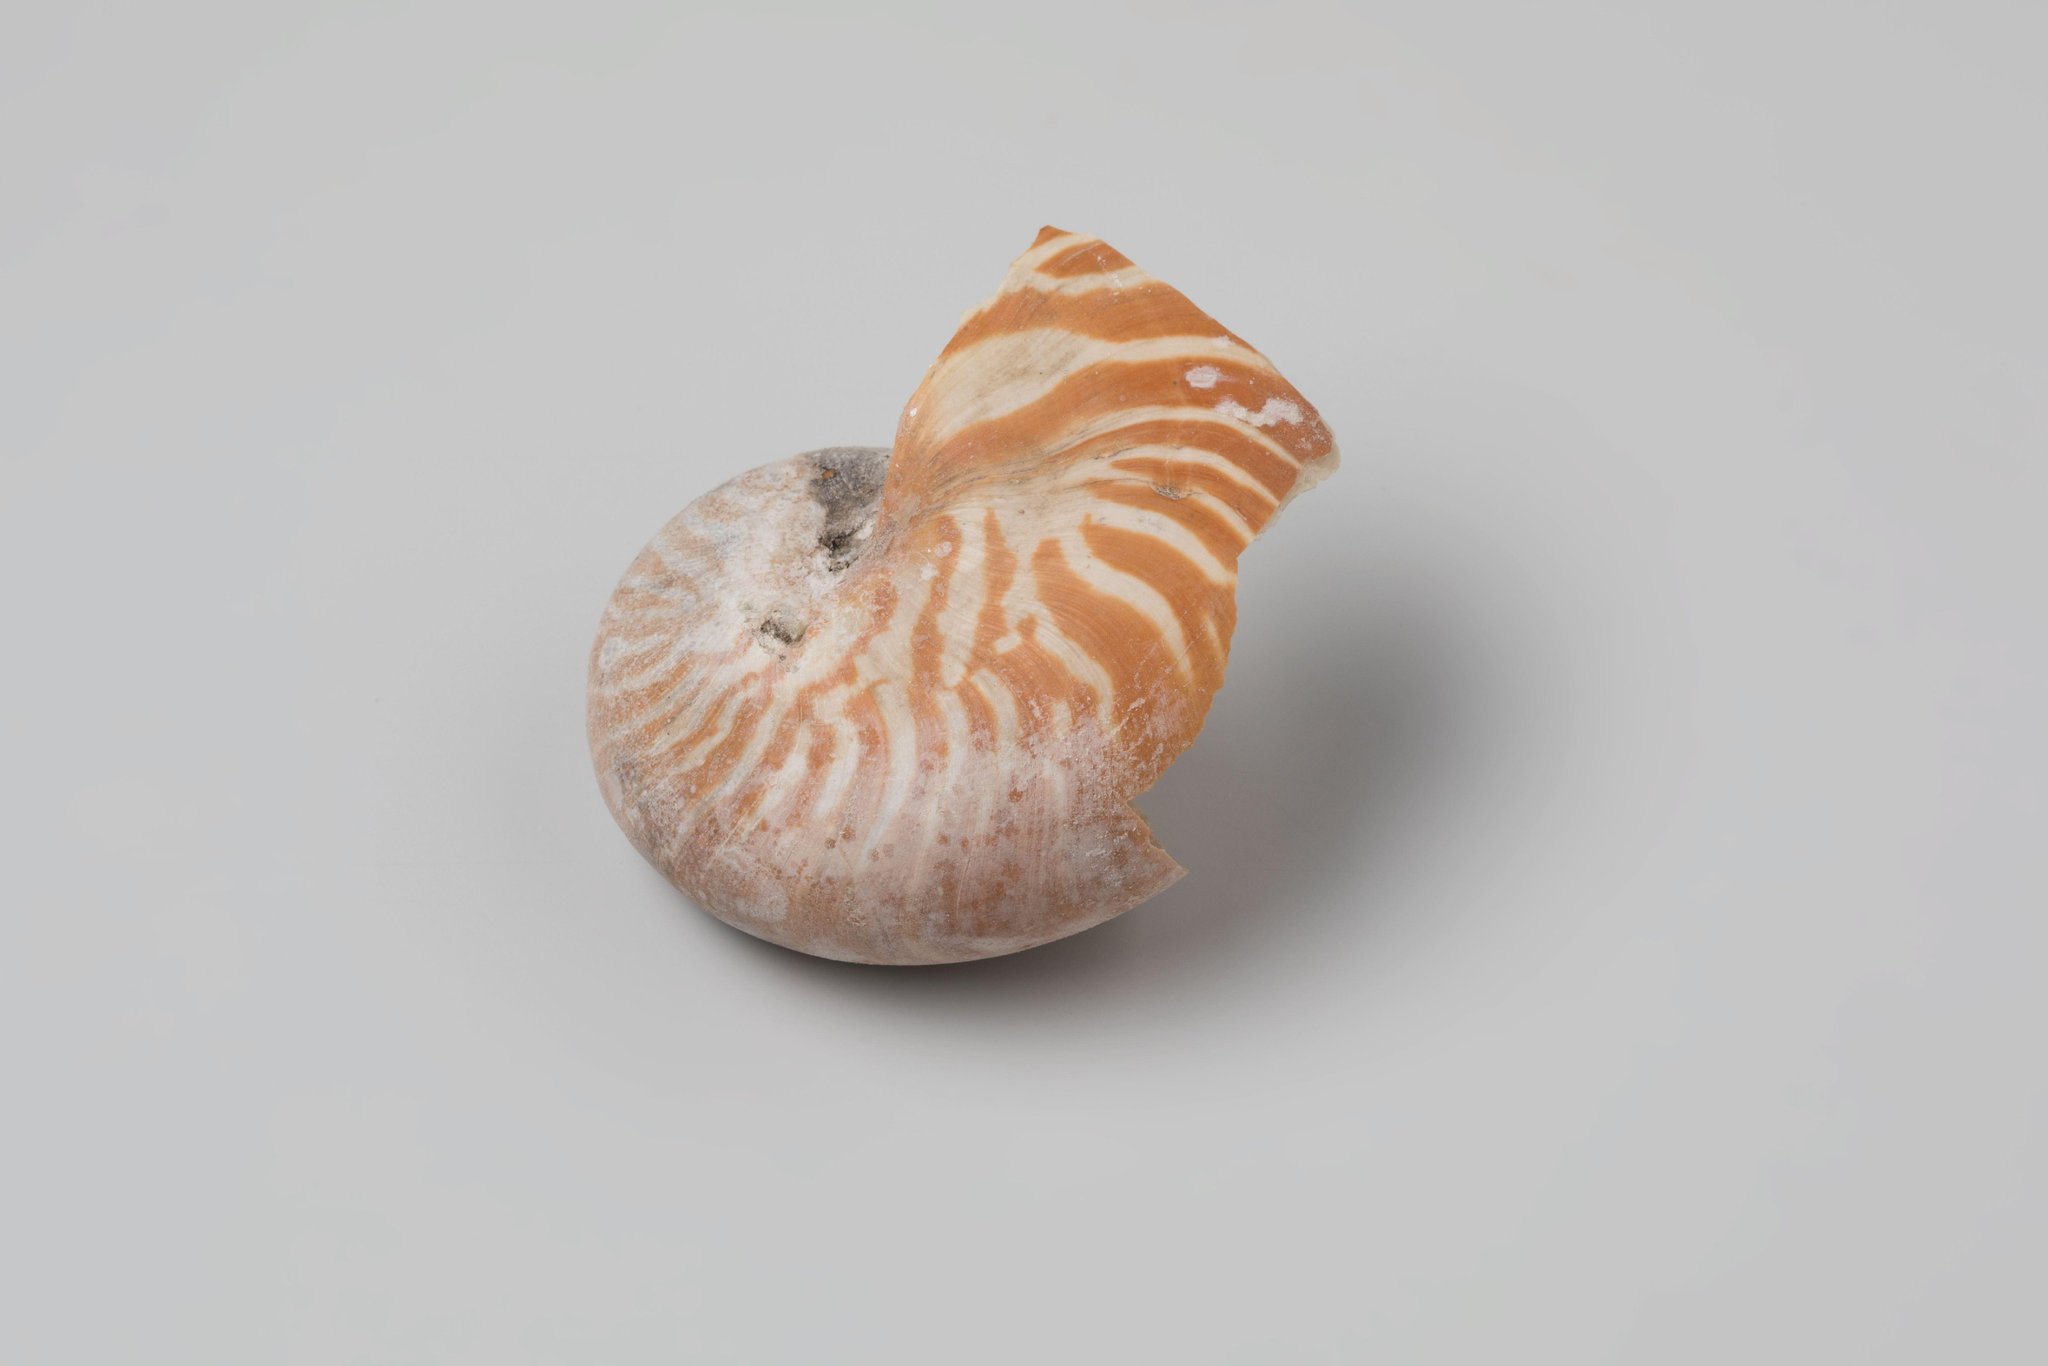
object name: nautilus pompilius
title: Nautilus pompilius shell from the wreck of the Dutch East India ship Witte Leeuw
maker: niet van toepassing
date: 1613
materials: shell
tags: verenigde oostindische compagnie, sint-helena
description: Schelp van een inktvis uit V.O.C.-schip de 'Witte Leeuw'.